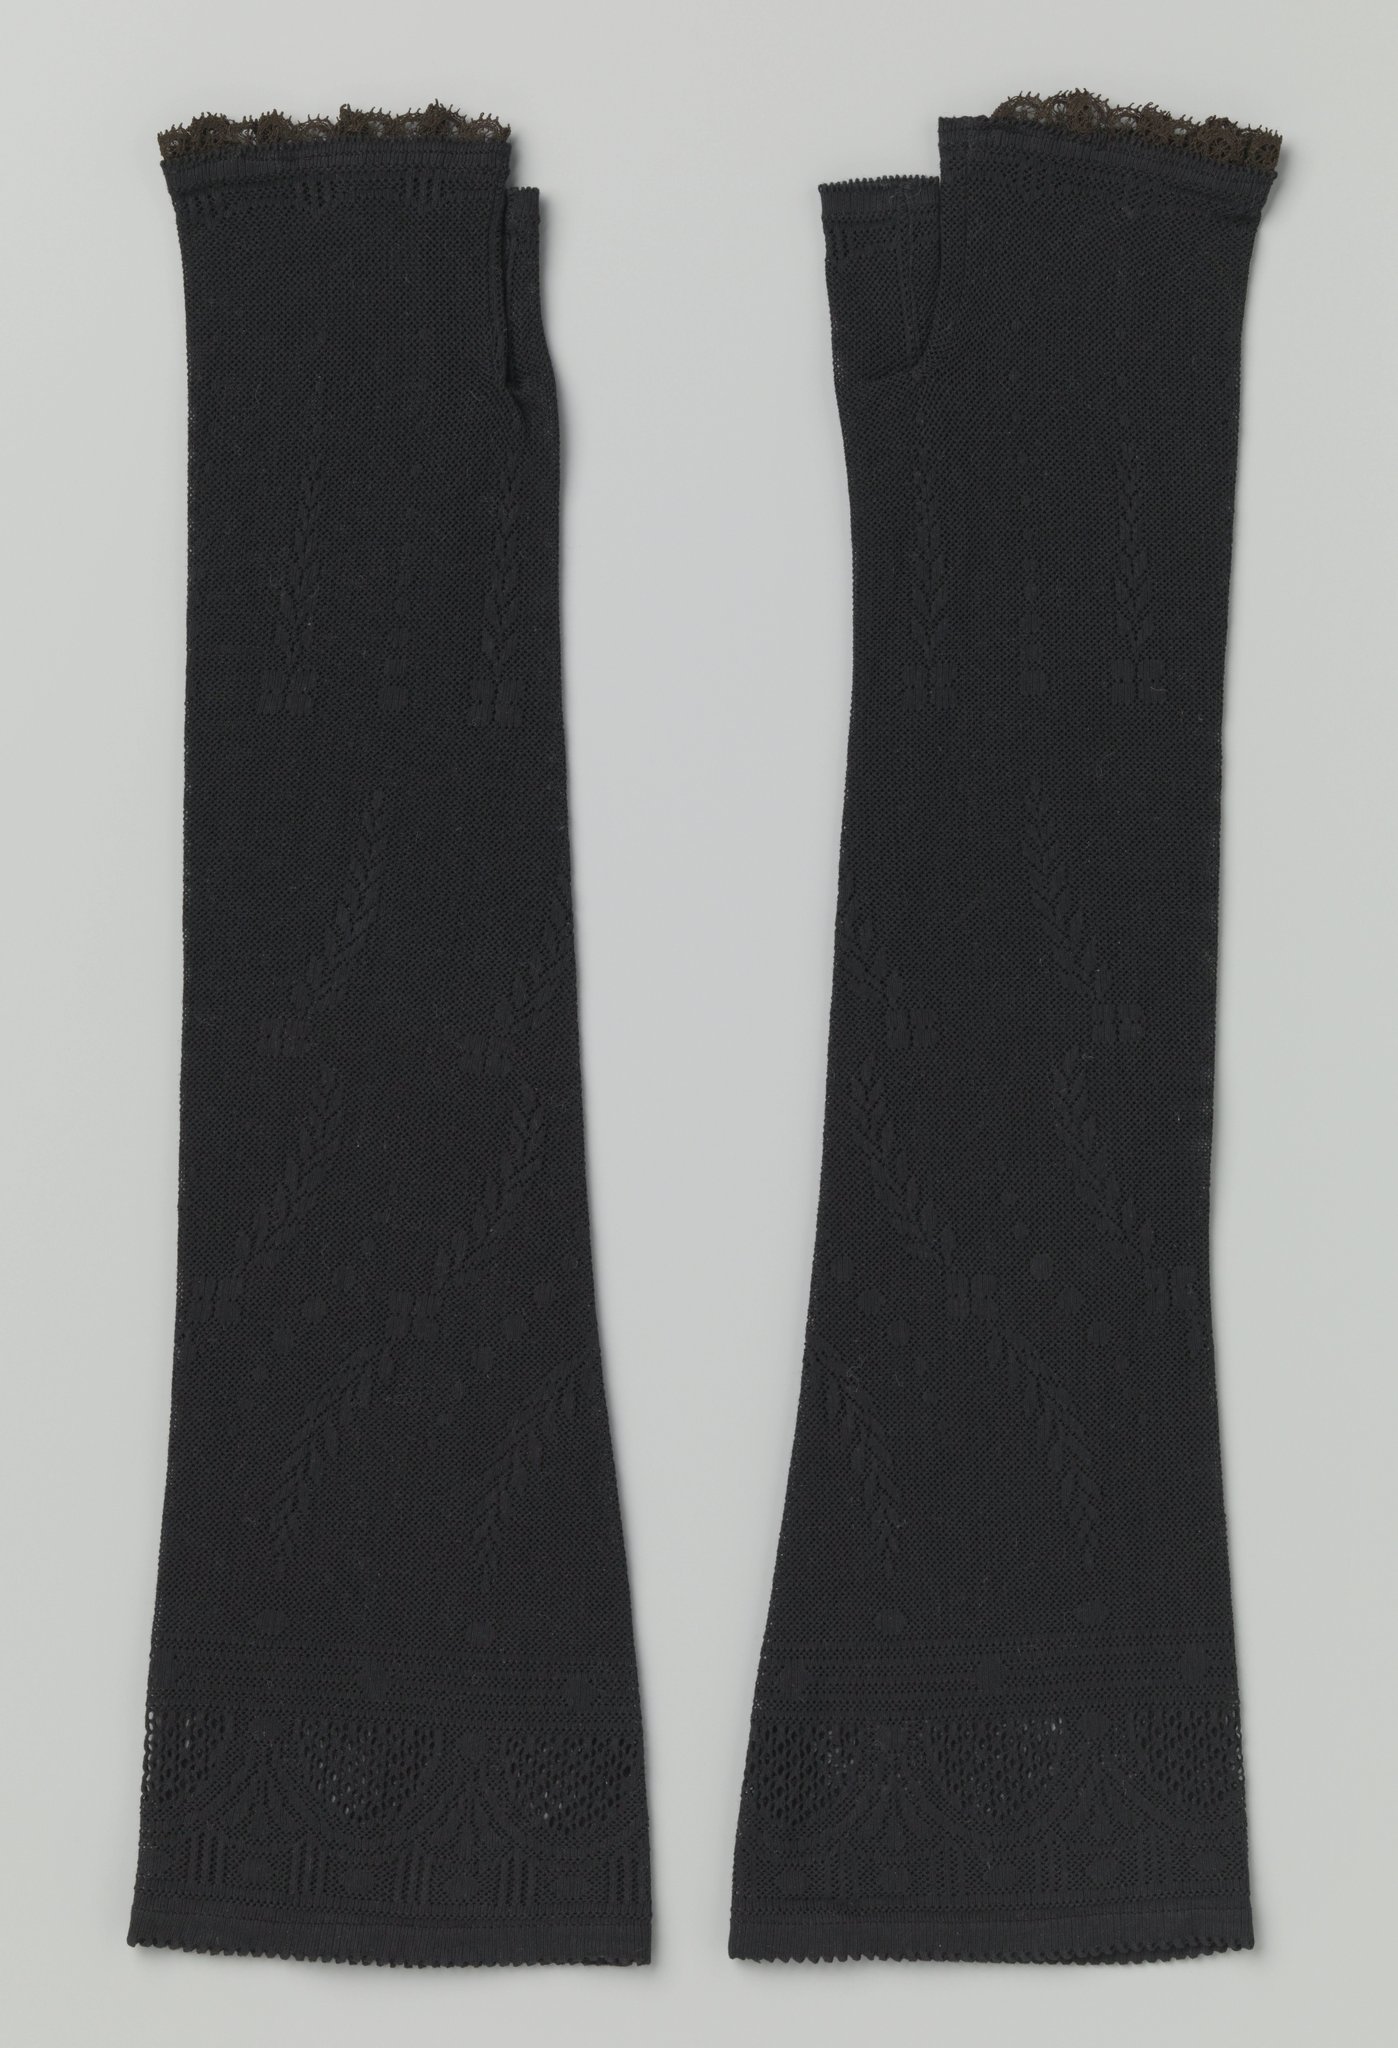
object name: clothing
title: Mitaine van zwarte katoen in machinaal kant, met losse duim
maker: Anonymous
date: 1900-1925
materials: cotton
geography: western europe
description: Rechtermitaine van zwart katoen van machinale kant. Recht afgesneden over de hand, met losse duim. Afgezet met een smal randje bruin kant. Ornament van bladeren, waartussen pastilles. Aan de bovenkant een rand met architectonische vormen.